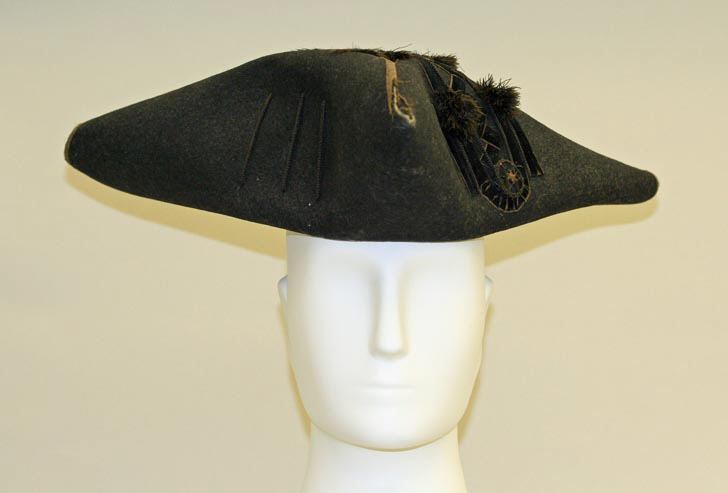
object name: tricorne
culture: austrian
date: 1701-1800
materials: silk, silver